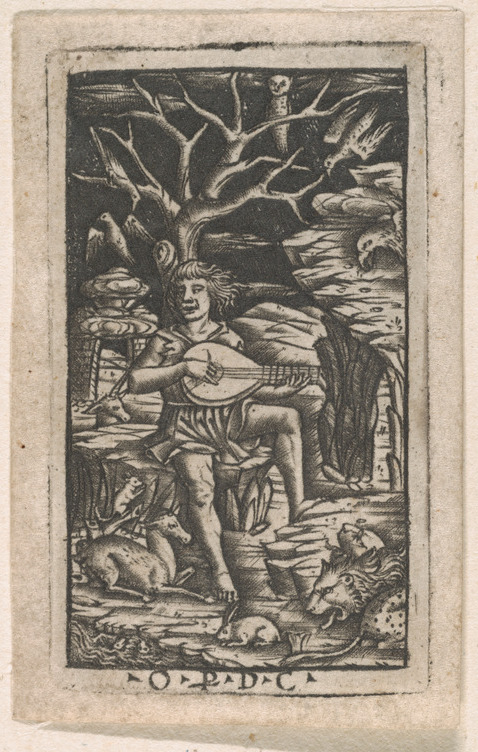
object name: print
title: Orpheus seated playing his lyre, and charming the animals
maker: peregrino da cesena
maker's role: artist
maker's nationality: italian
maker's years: 1450-1520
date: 1500-1520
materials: niello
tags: musical instruments,orpheus,owls,deer,rabbits